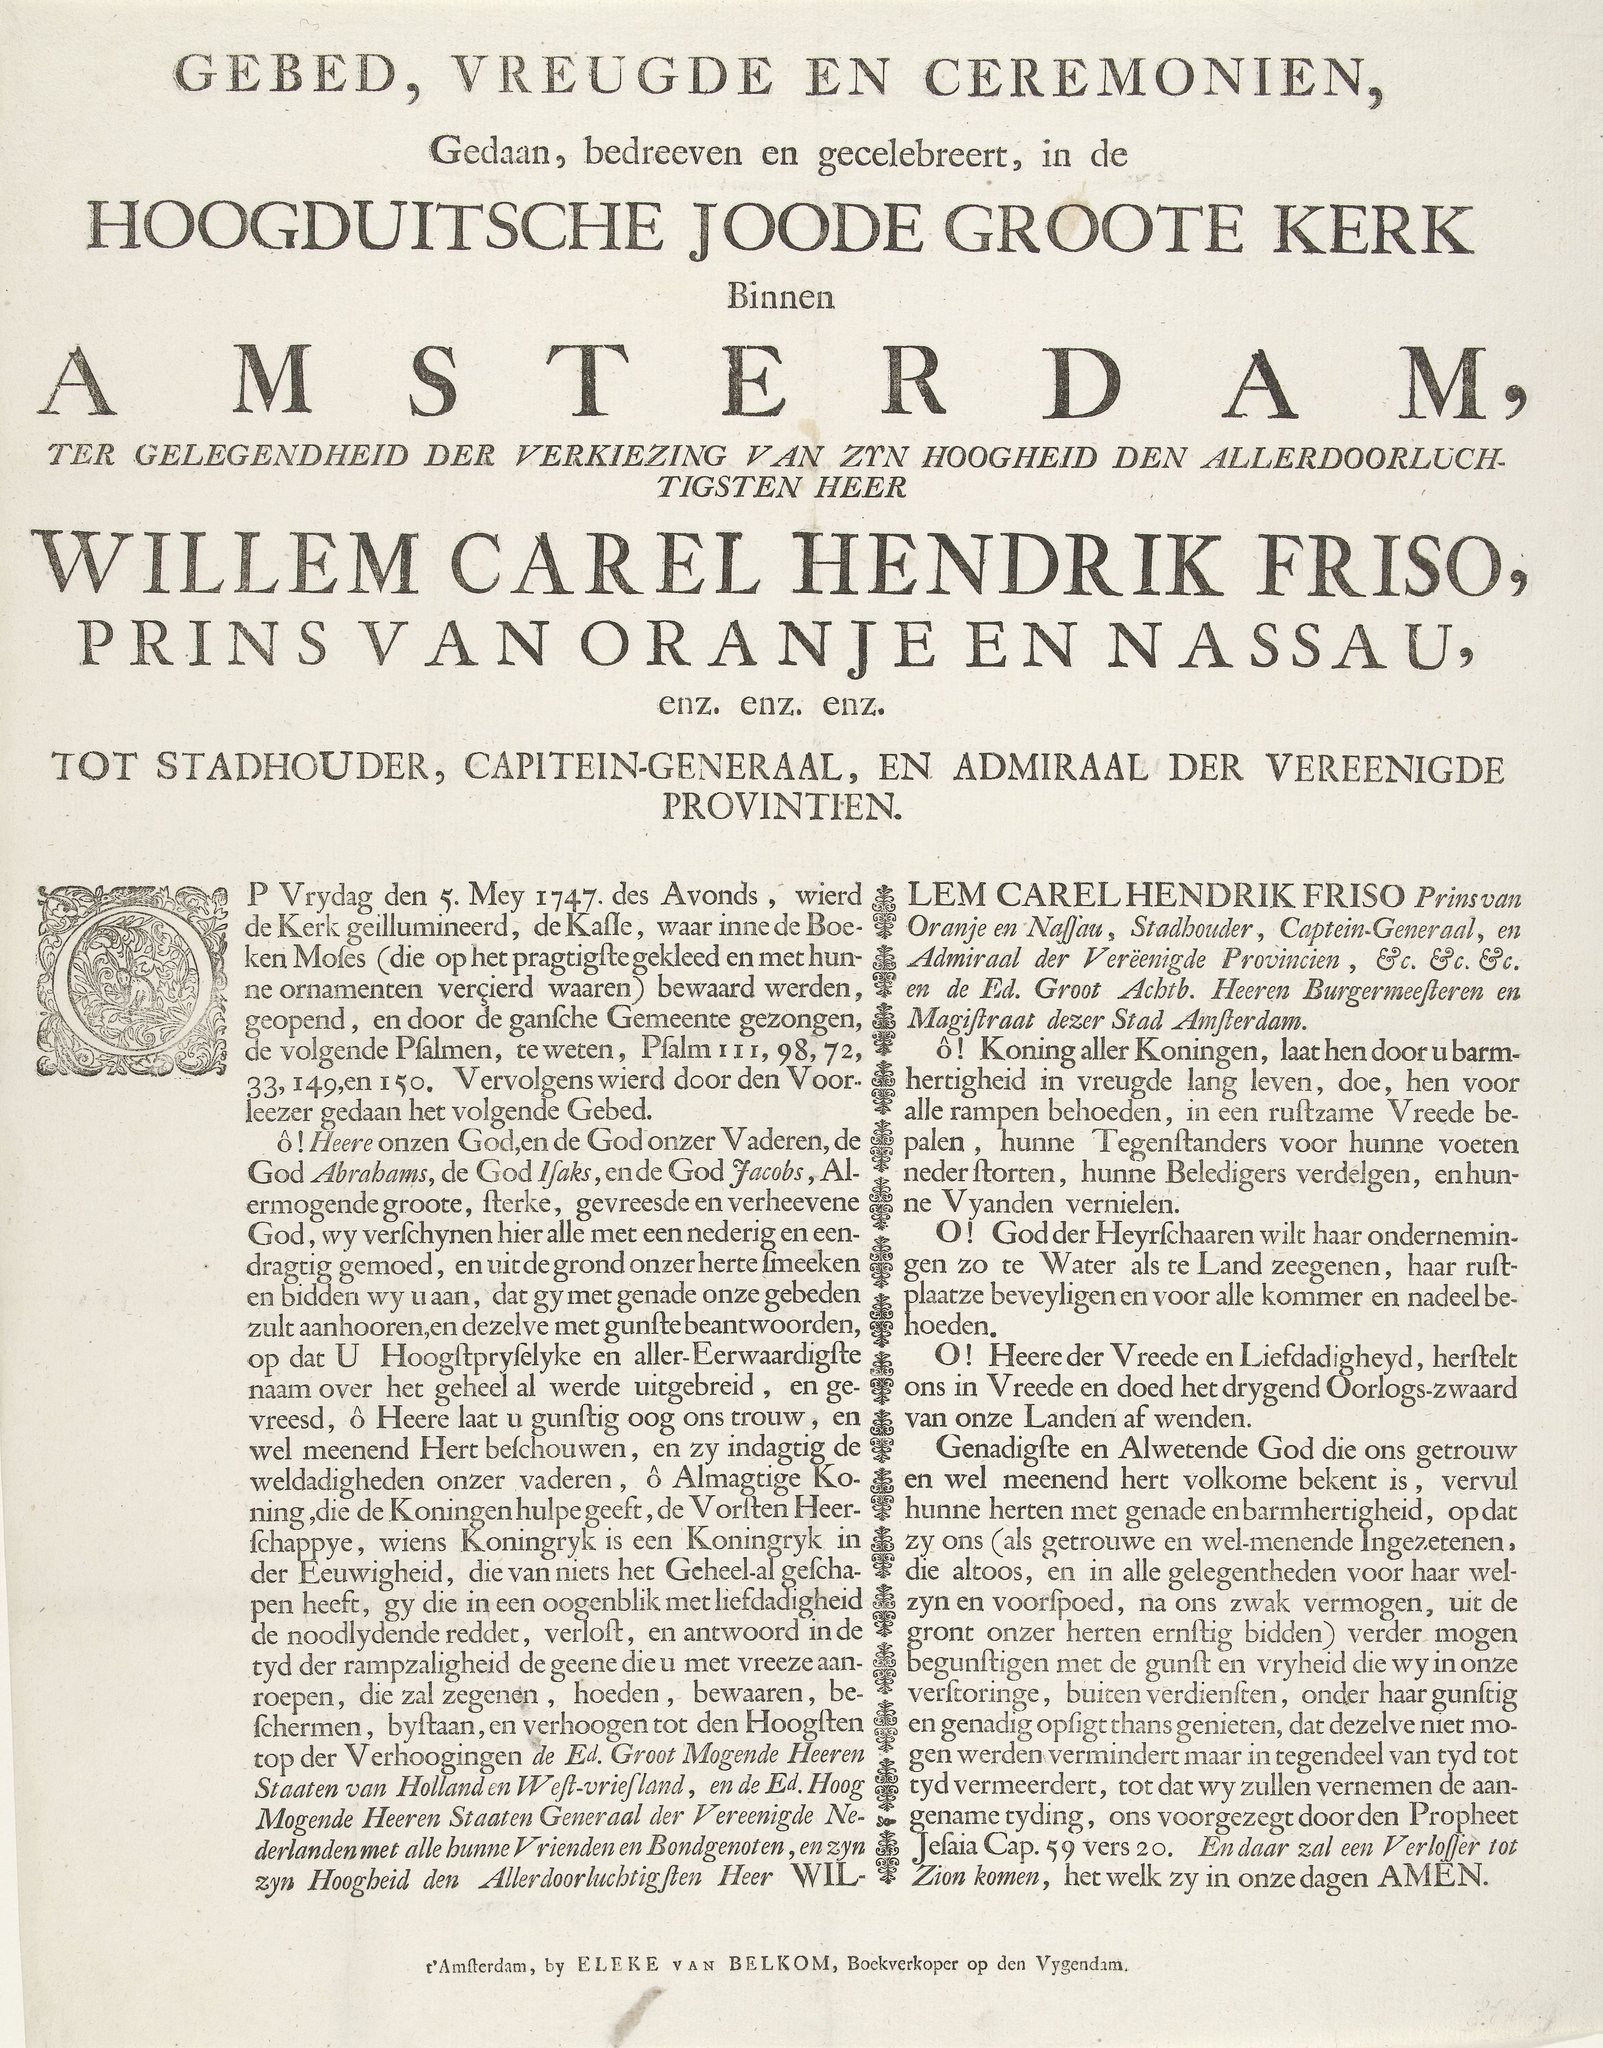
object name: text sheet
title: Gebed, Vreugde en Ceremonien, Gedaan, bedreeven en gecelebreert, in de Hoogduitsche Joode Groote Kerk Binnen Amsterdam, ter gelegenheid der verkiezing van zyn hoogheid den allerdoorluchtigsten heer Willem Carel Hendrik Friso, Prins van Oranje en Nassau (...) tot Stadhouder, Capitein-Generaal en Admiraal der Vereenigde Provintien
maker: eleke van belkom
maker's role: publisher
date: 1747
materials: paper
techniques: letterpress printing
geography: amsterdam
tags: the hague, willem iv (prins van oranje-nassau)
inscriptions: collector's mark: Lugt 2228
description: Tekstblad met het gebed uitgesproken in de Hoogduitse Synagoge te Amsterdam bij de benoeming van Prins Willem IV als stadhouder van Holland, 5 Mei 1747.